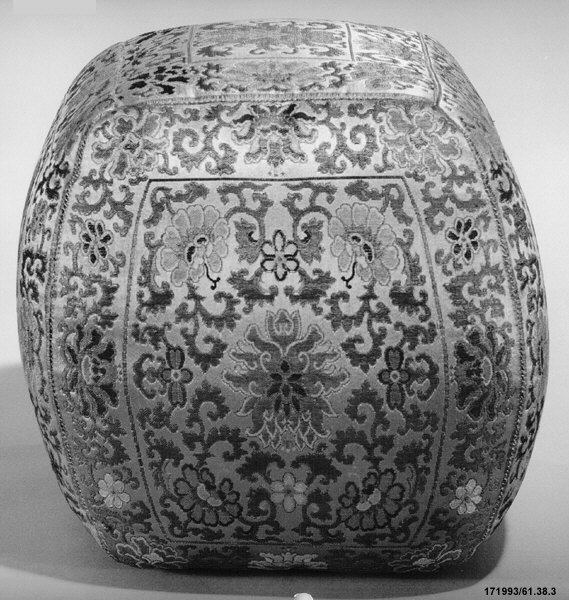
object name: cushion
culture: chinese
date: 1867-1900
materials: silk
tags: flowers